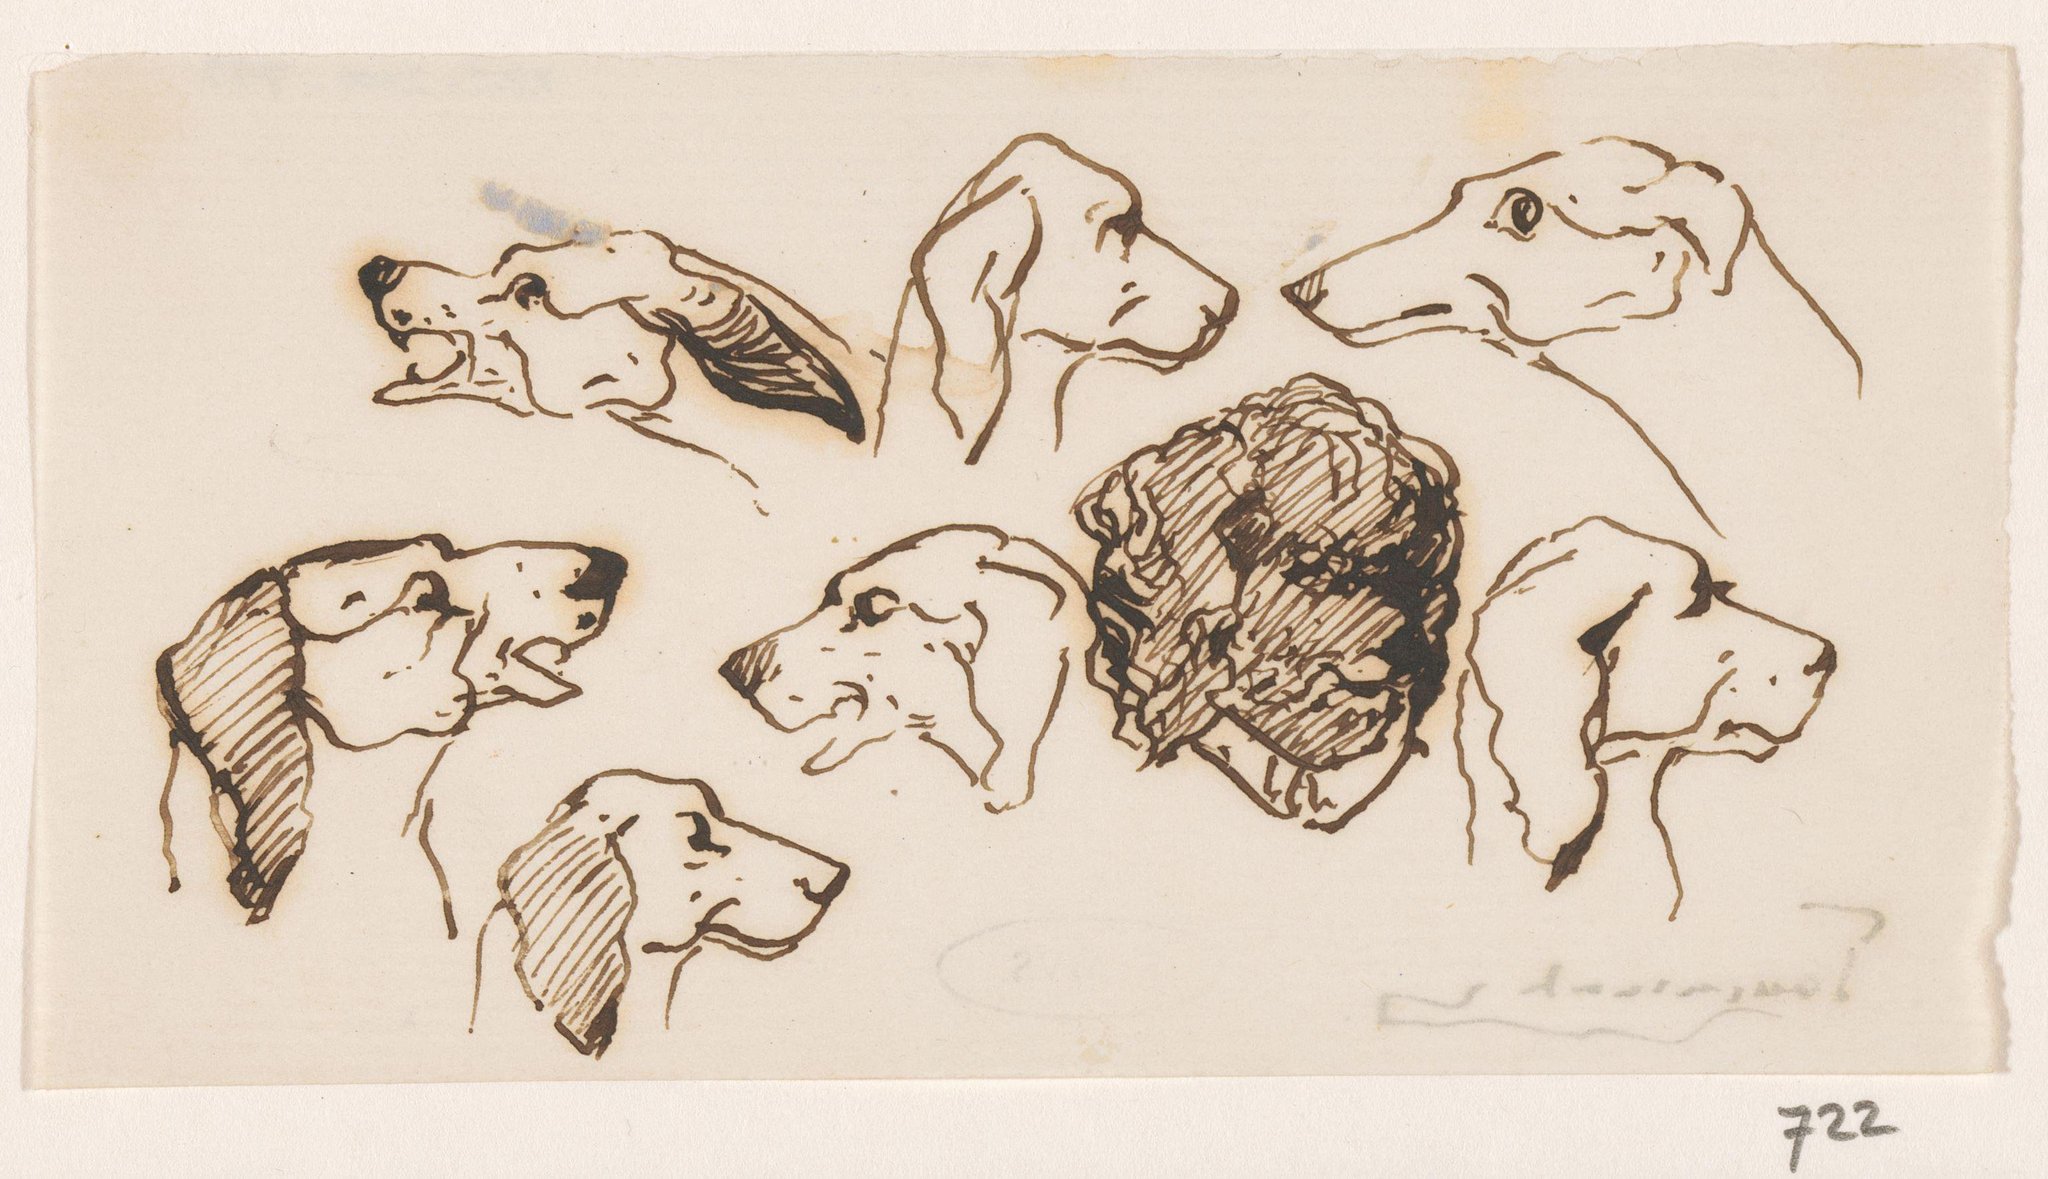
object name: drawing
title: Hondenkoppen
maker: johannes tavenraat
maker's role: draughtsman, painter, print maker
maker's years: 1809-1881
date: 1840-1880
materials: ink, paper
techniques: pen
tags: hunting dogs, dog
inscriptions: collector's mark: Lugt 2228, signature: ‘Tavenraat’